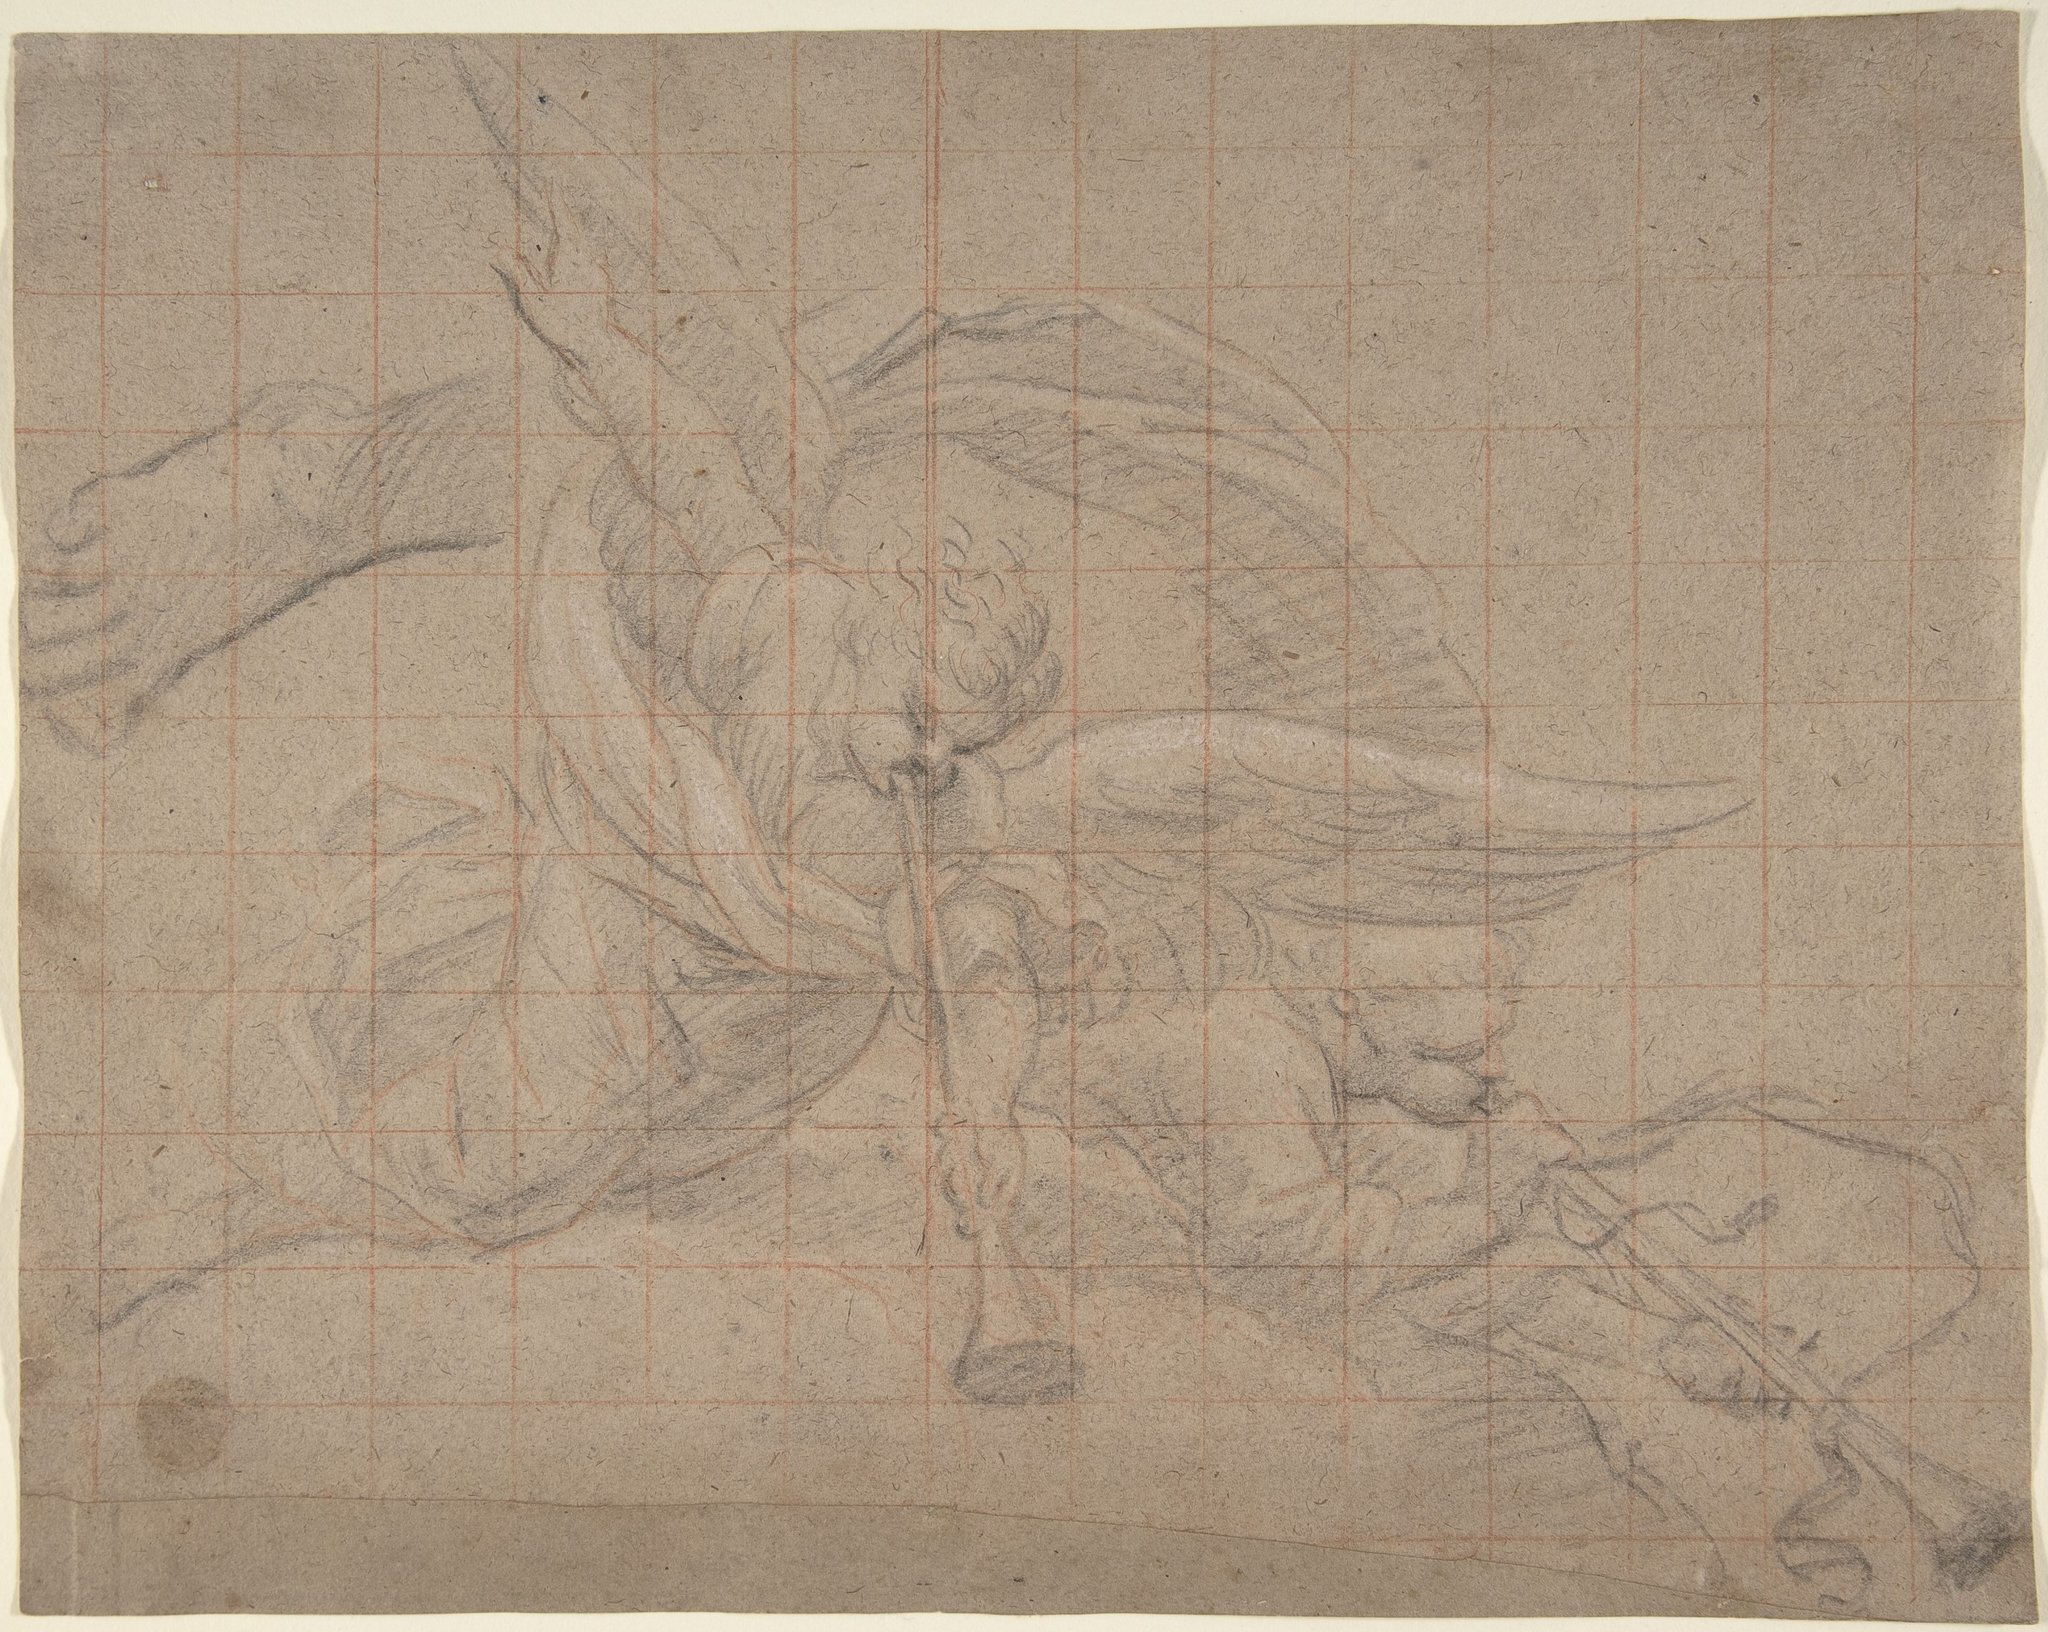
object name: drawing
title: Two Angels, Study for the Val de Grâce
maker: pierre mignard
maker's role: artist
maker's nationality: french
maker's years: 1612-1695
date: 1601-1700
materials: chalk, paper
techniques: heightening, drawing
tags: musical instruments,angels